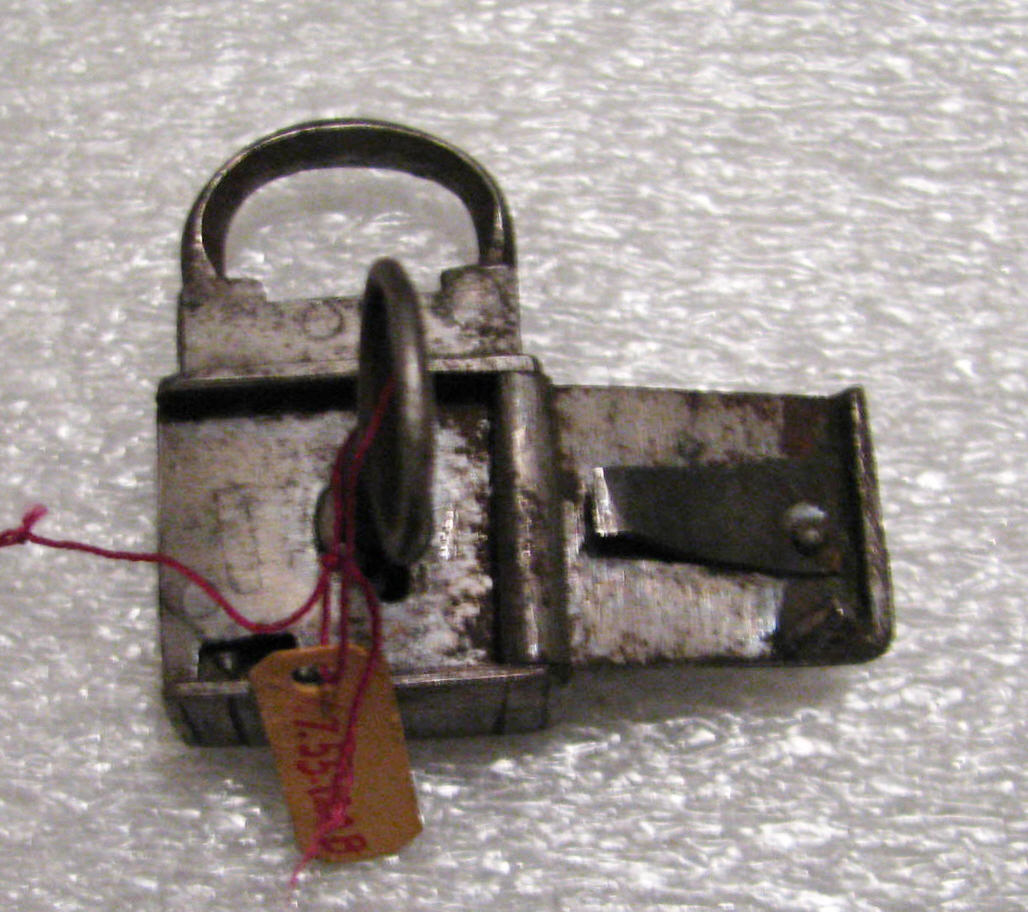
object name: padlock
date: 1501-1700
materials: steel